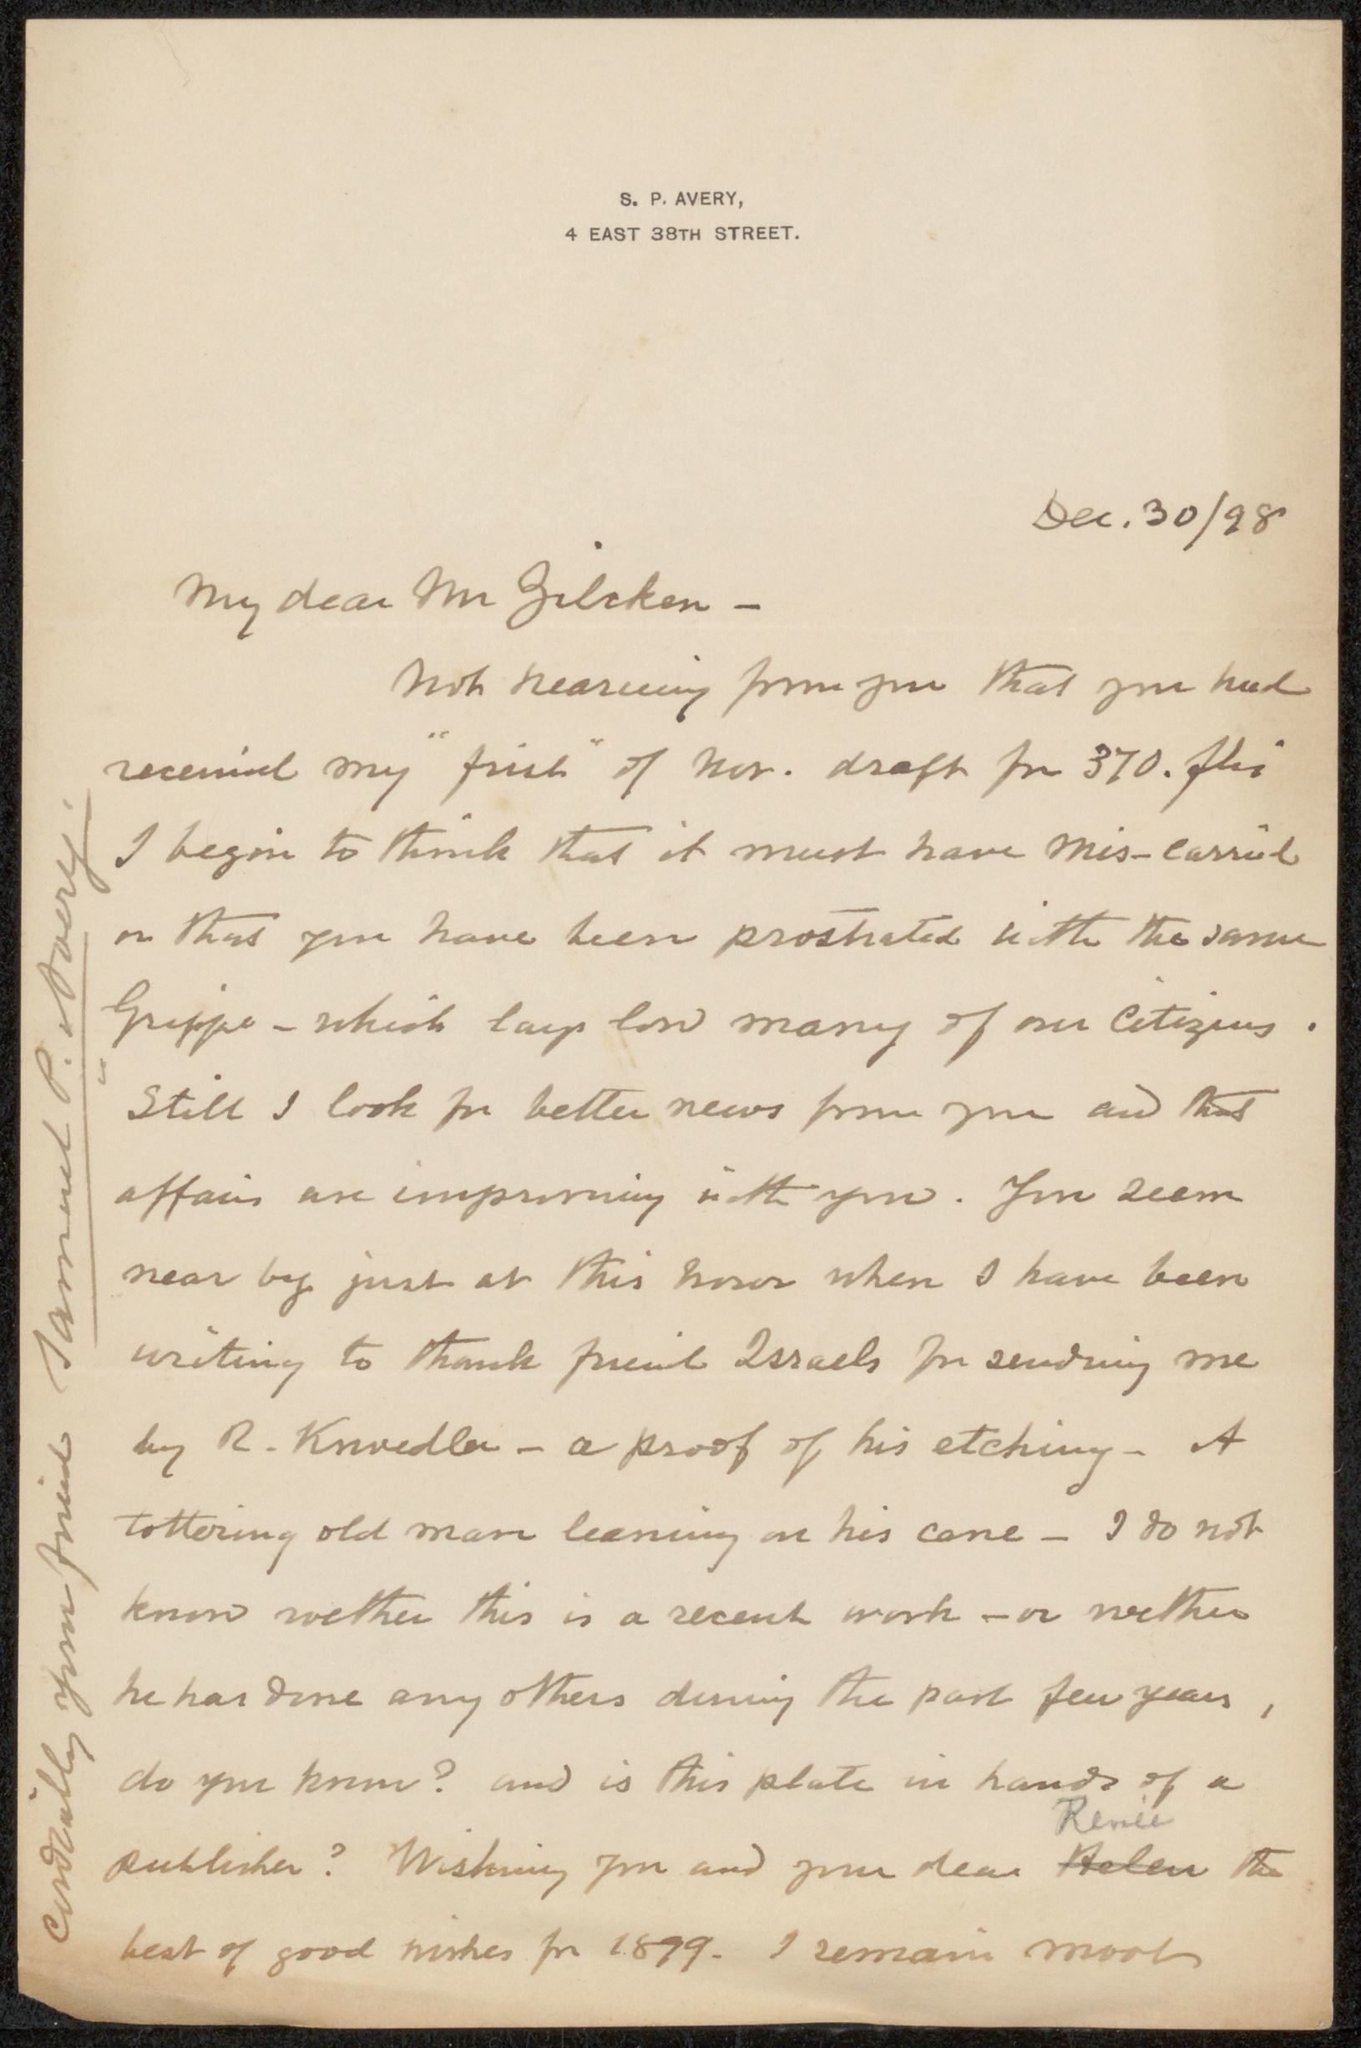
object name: letter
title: Brief aan Philip Zilcken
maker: samuel putnam avery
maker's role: verzamelaar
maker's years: 1822-1904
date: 1898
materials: ink, paper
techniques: pen, printing, writing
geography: new york city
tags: the hague, painter, draughtsman, philip zilcken, the graphic arts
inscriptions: collector's mark: ‘RPK’